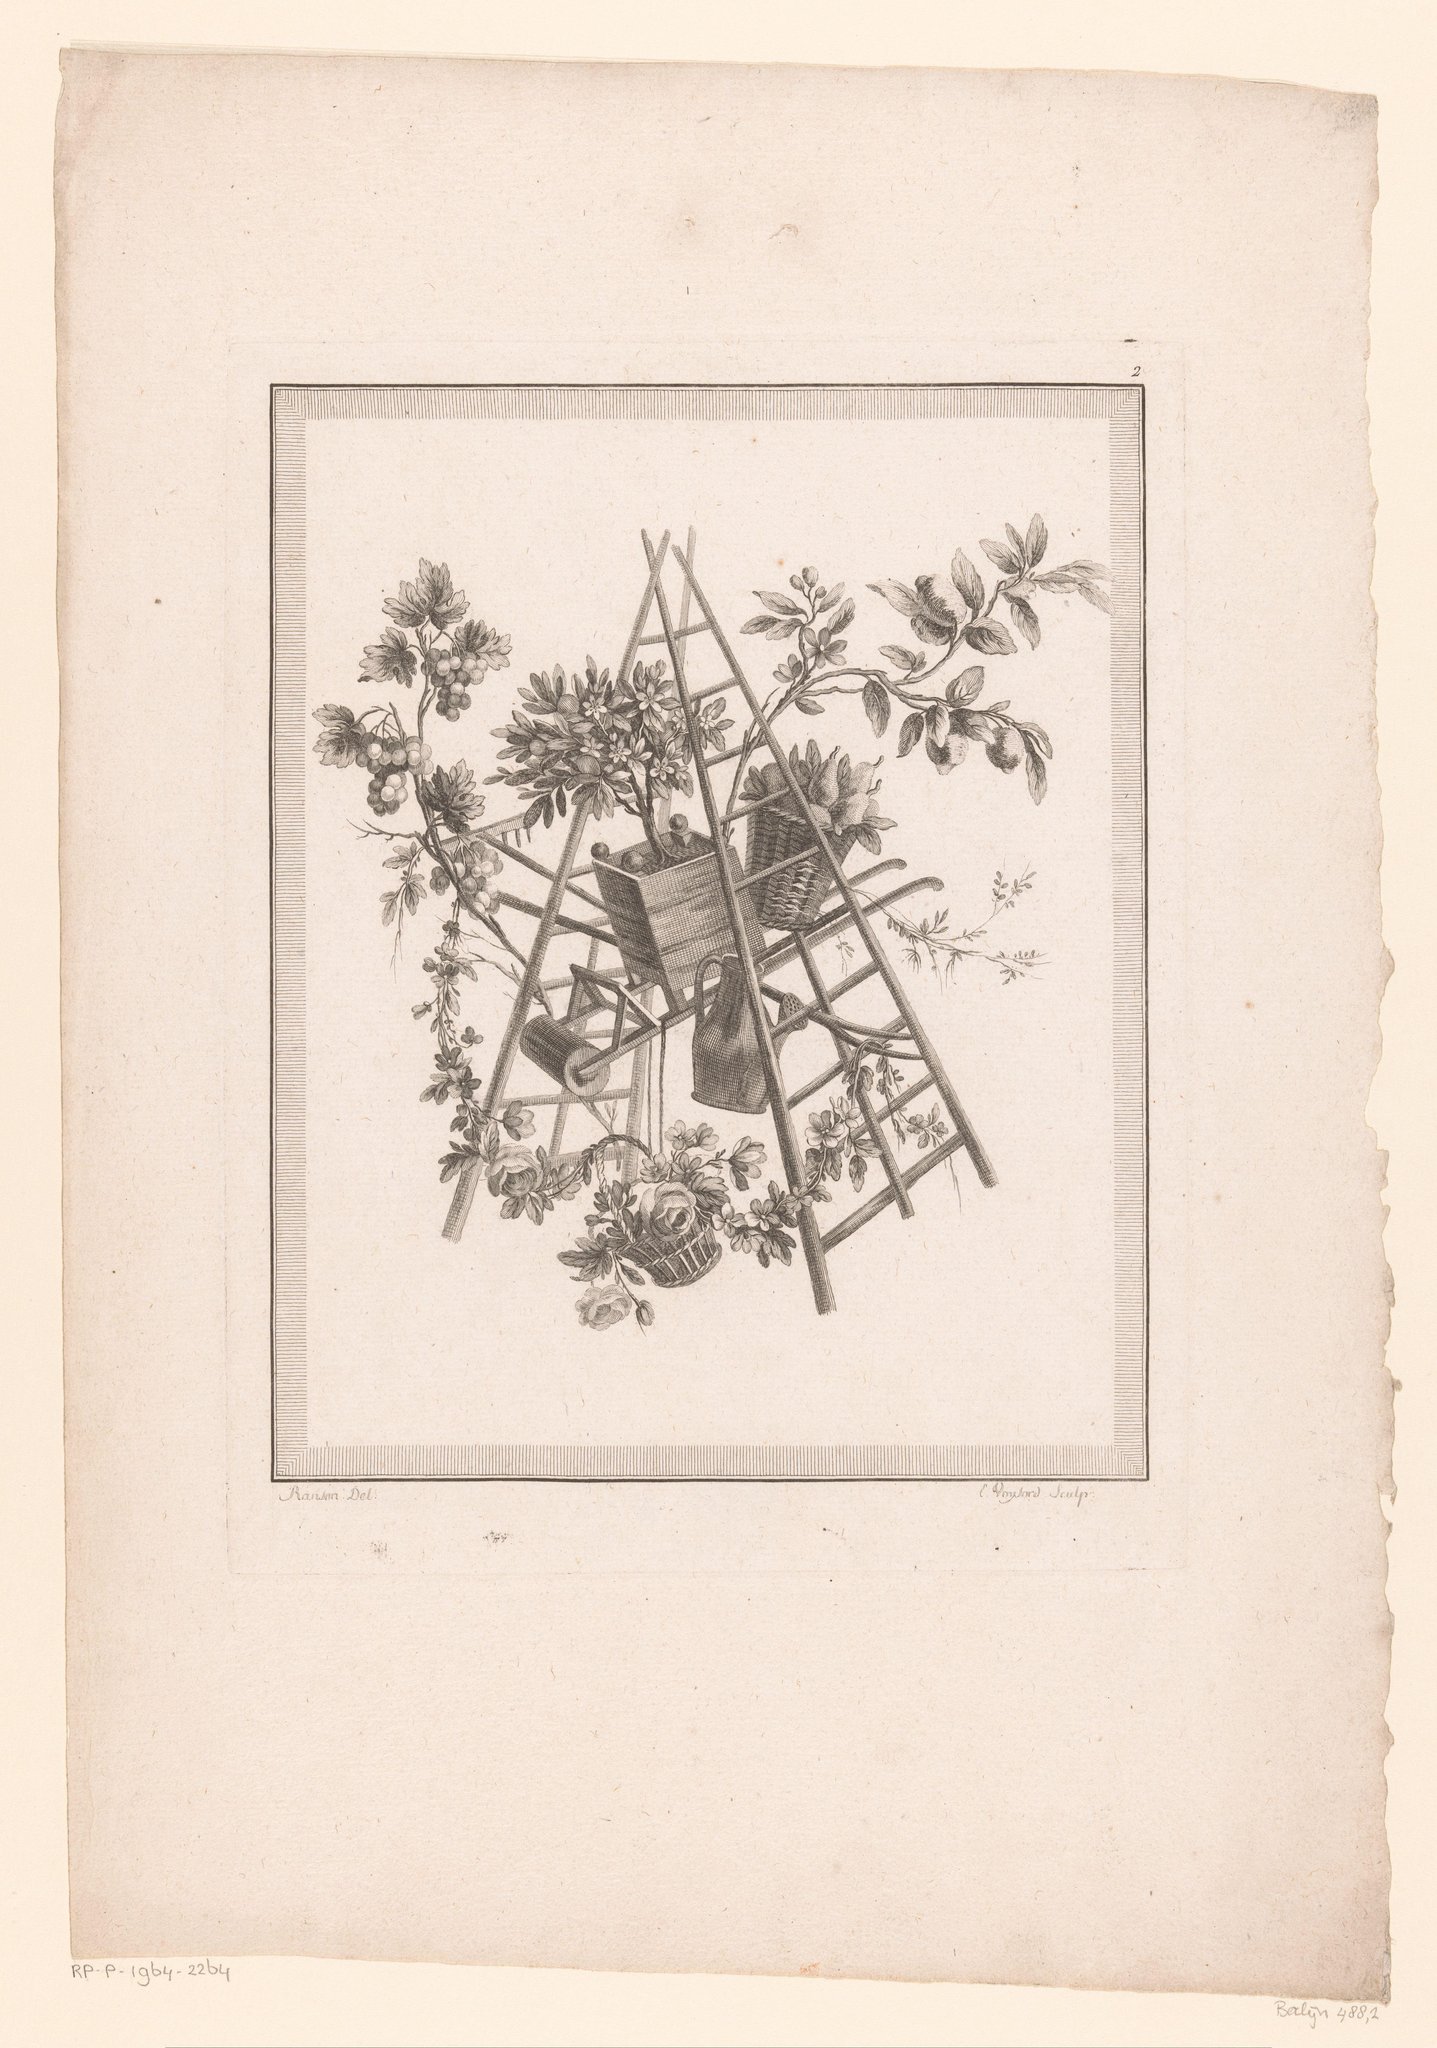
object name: print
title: 2e Suite de différens Attributs, Trophées et Groupes de Fleurs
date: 1778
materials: paper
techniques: etching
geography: paris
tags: trophy, i.e.: decorative arrangement of symbolic or typical objects ~ ornament, gardening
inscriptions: collector's mark: Lugt 2228, collector's mark: Lugt 2760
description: Een trofee met objecten behorend bij tuinbouw zoals een ladder, een gieter, een kruiwagen, bomen en fruit.